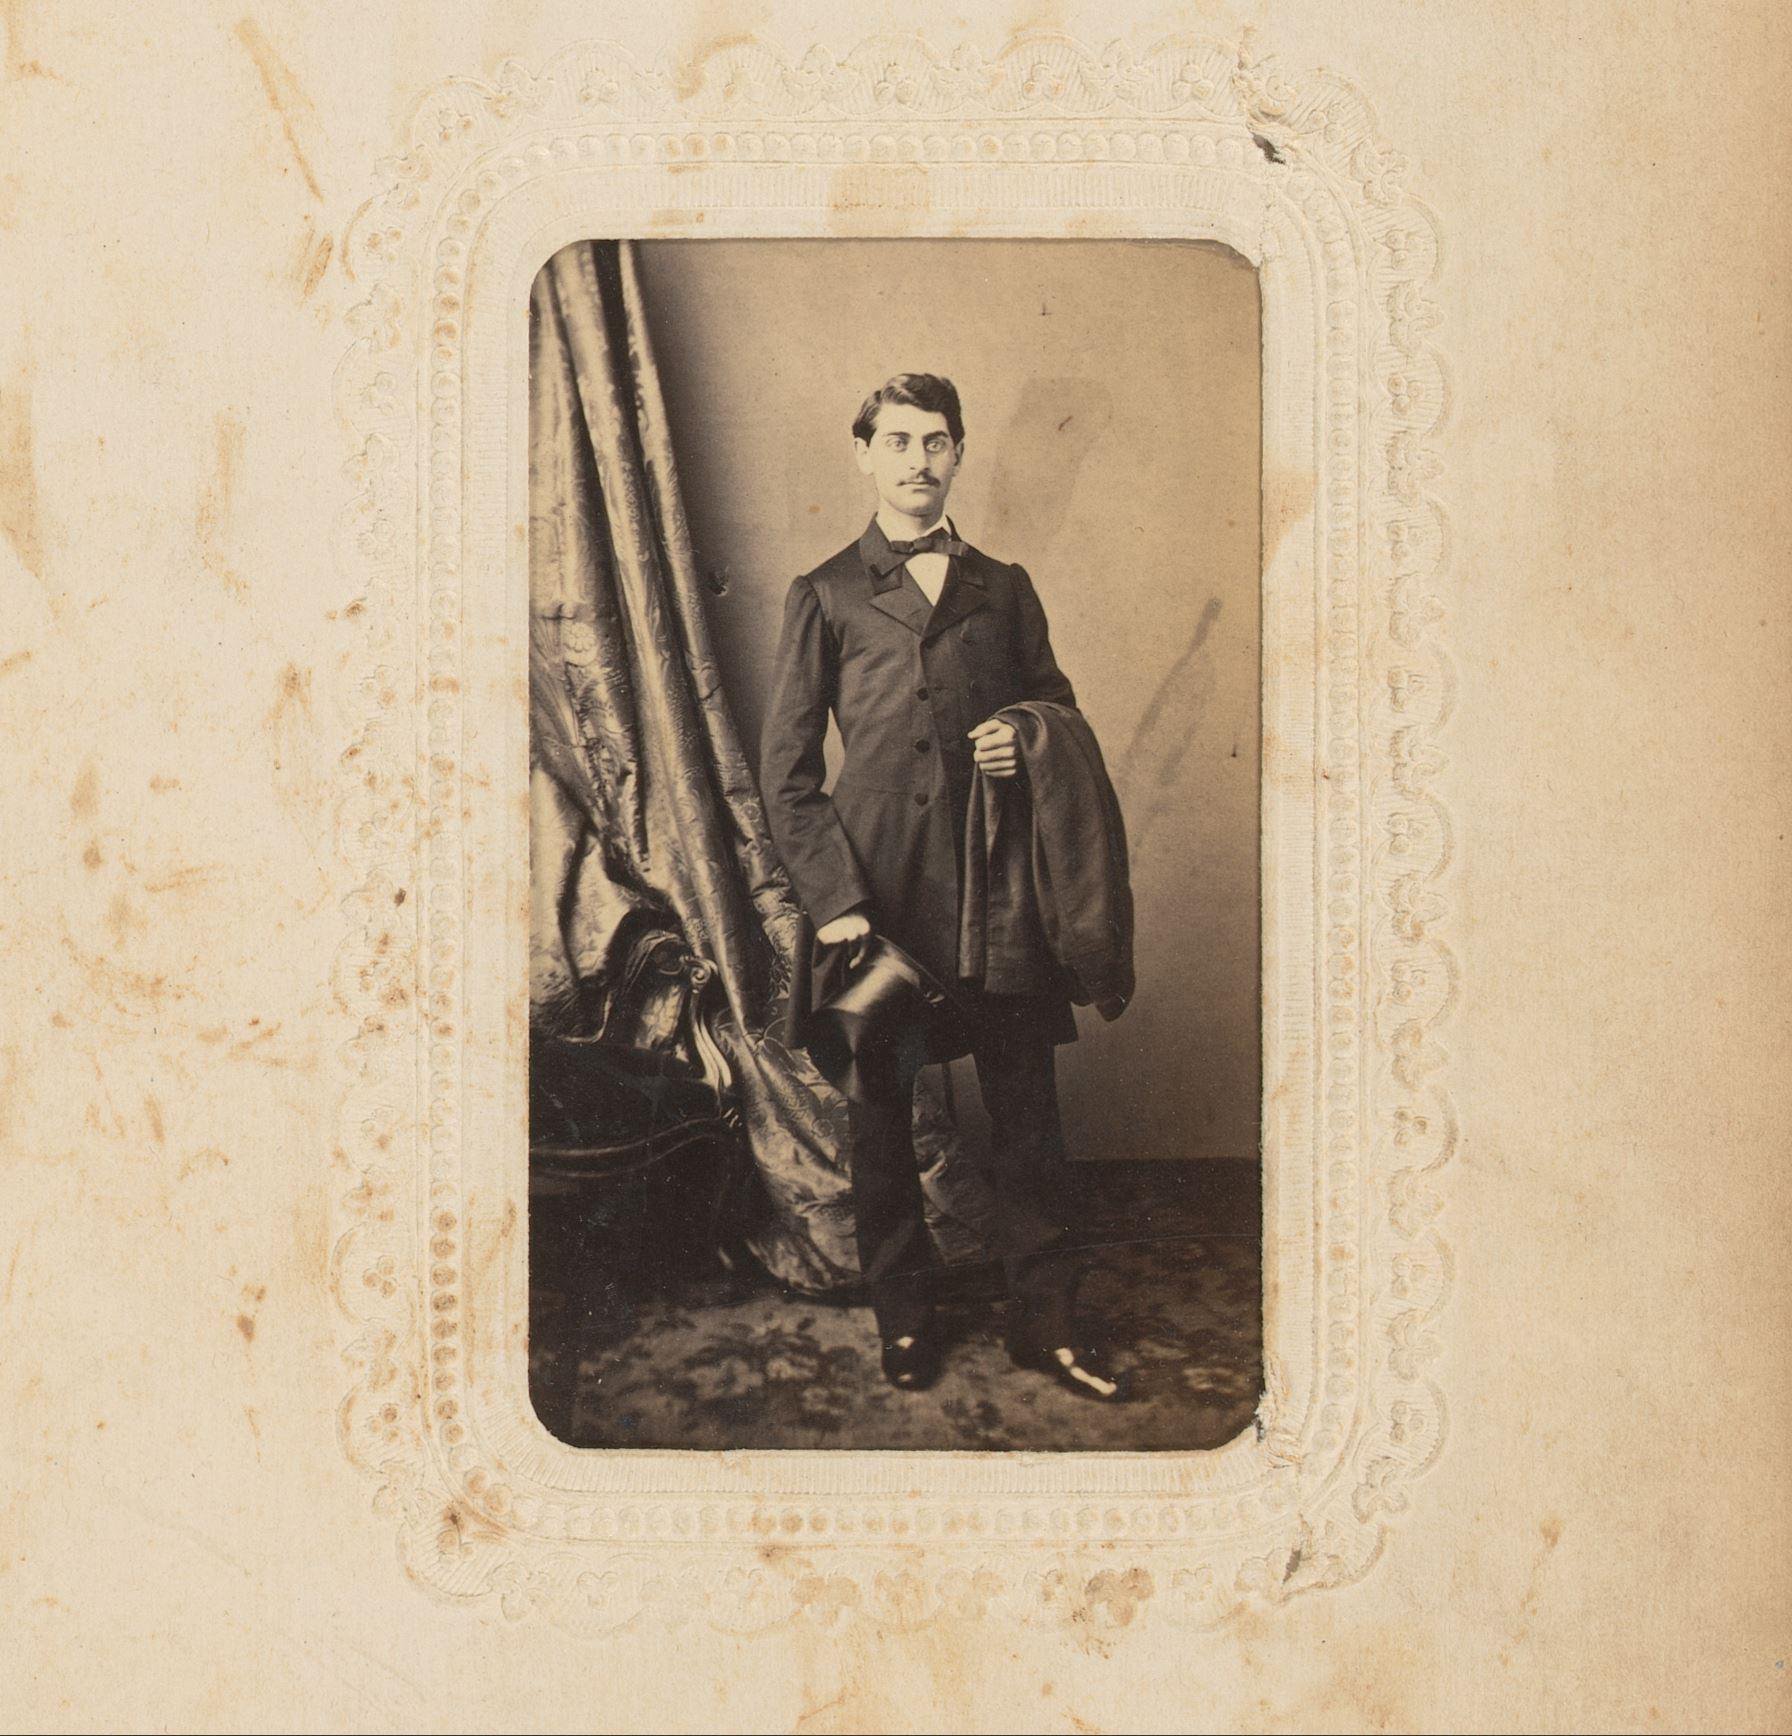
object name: carte de visite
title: Portret van een staande man met jas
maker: alphonse plumier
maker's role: fotograaf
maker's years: 1819-1877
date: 1850-1877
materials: cardboard, photographic support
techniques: albumen print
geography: brussels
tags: standing figure, historical persons, coat, cape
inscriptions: inscription: ‘Alph. Plumier/ photographie/ Passage St Hubert, 27, et rue d'Arenberg’